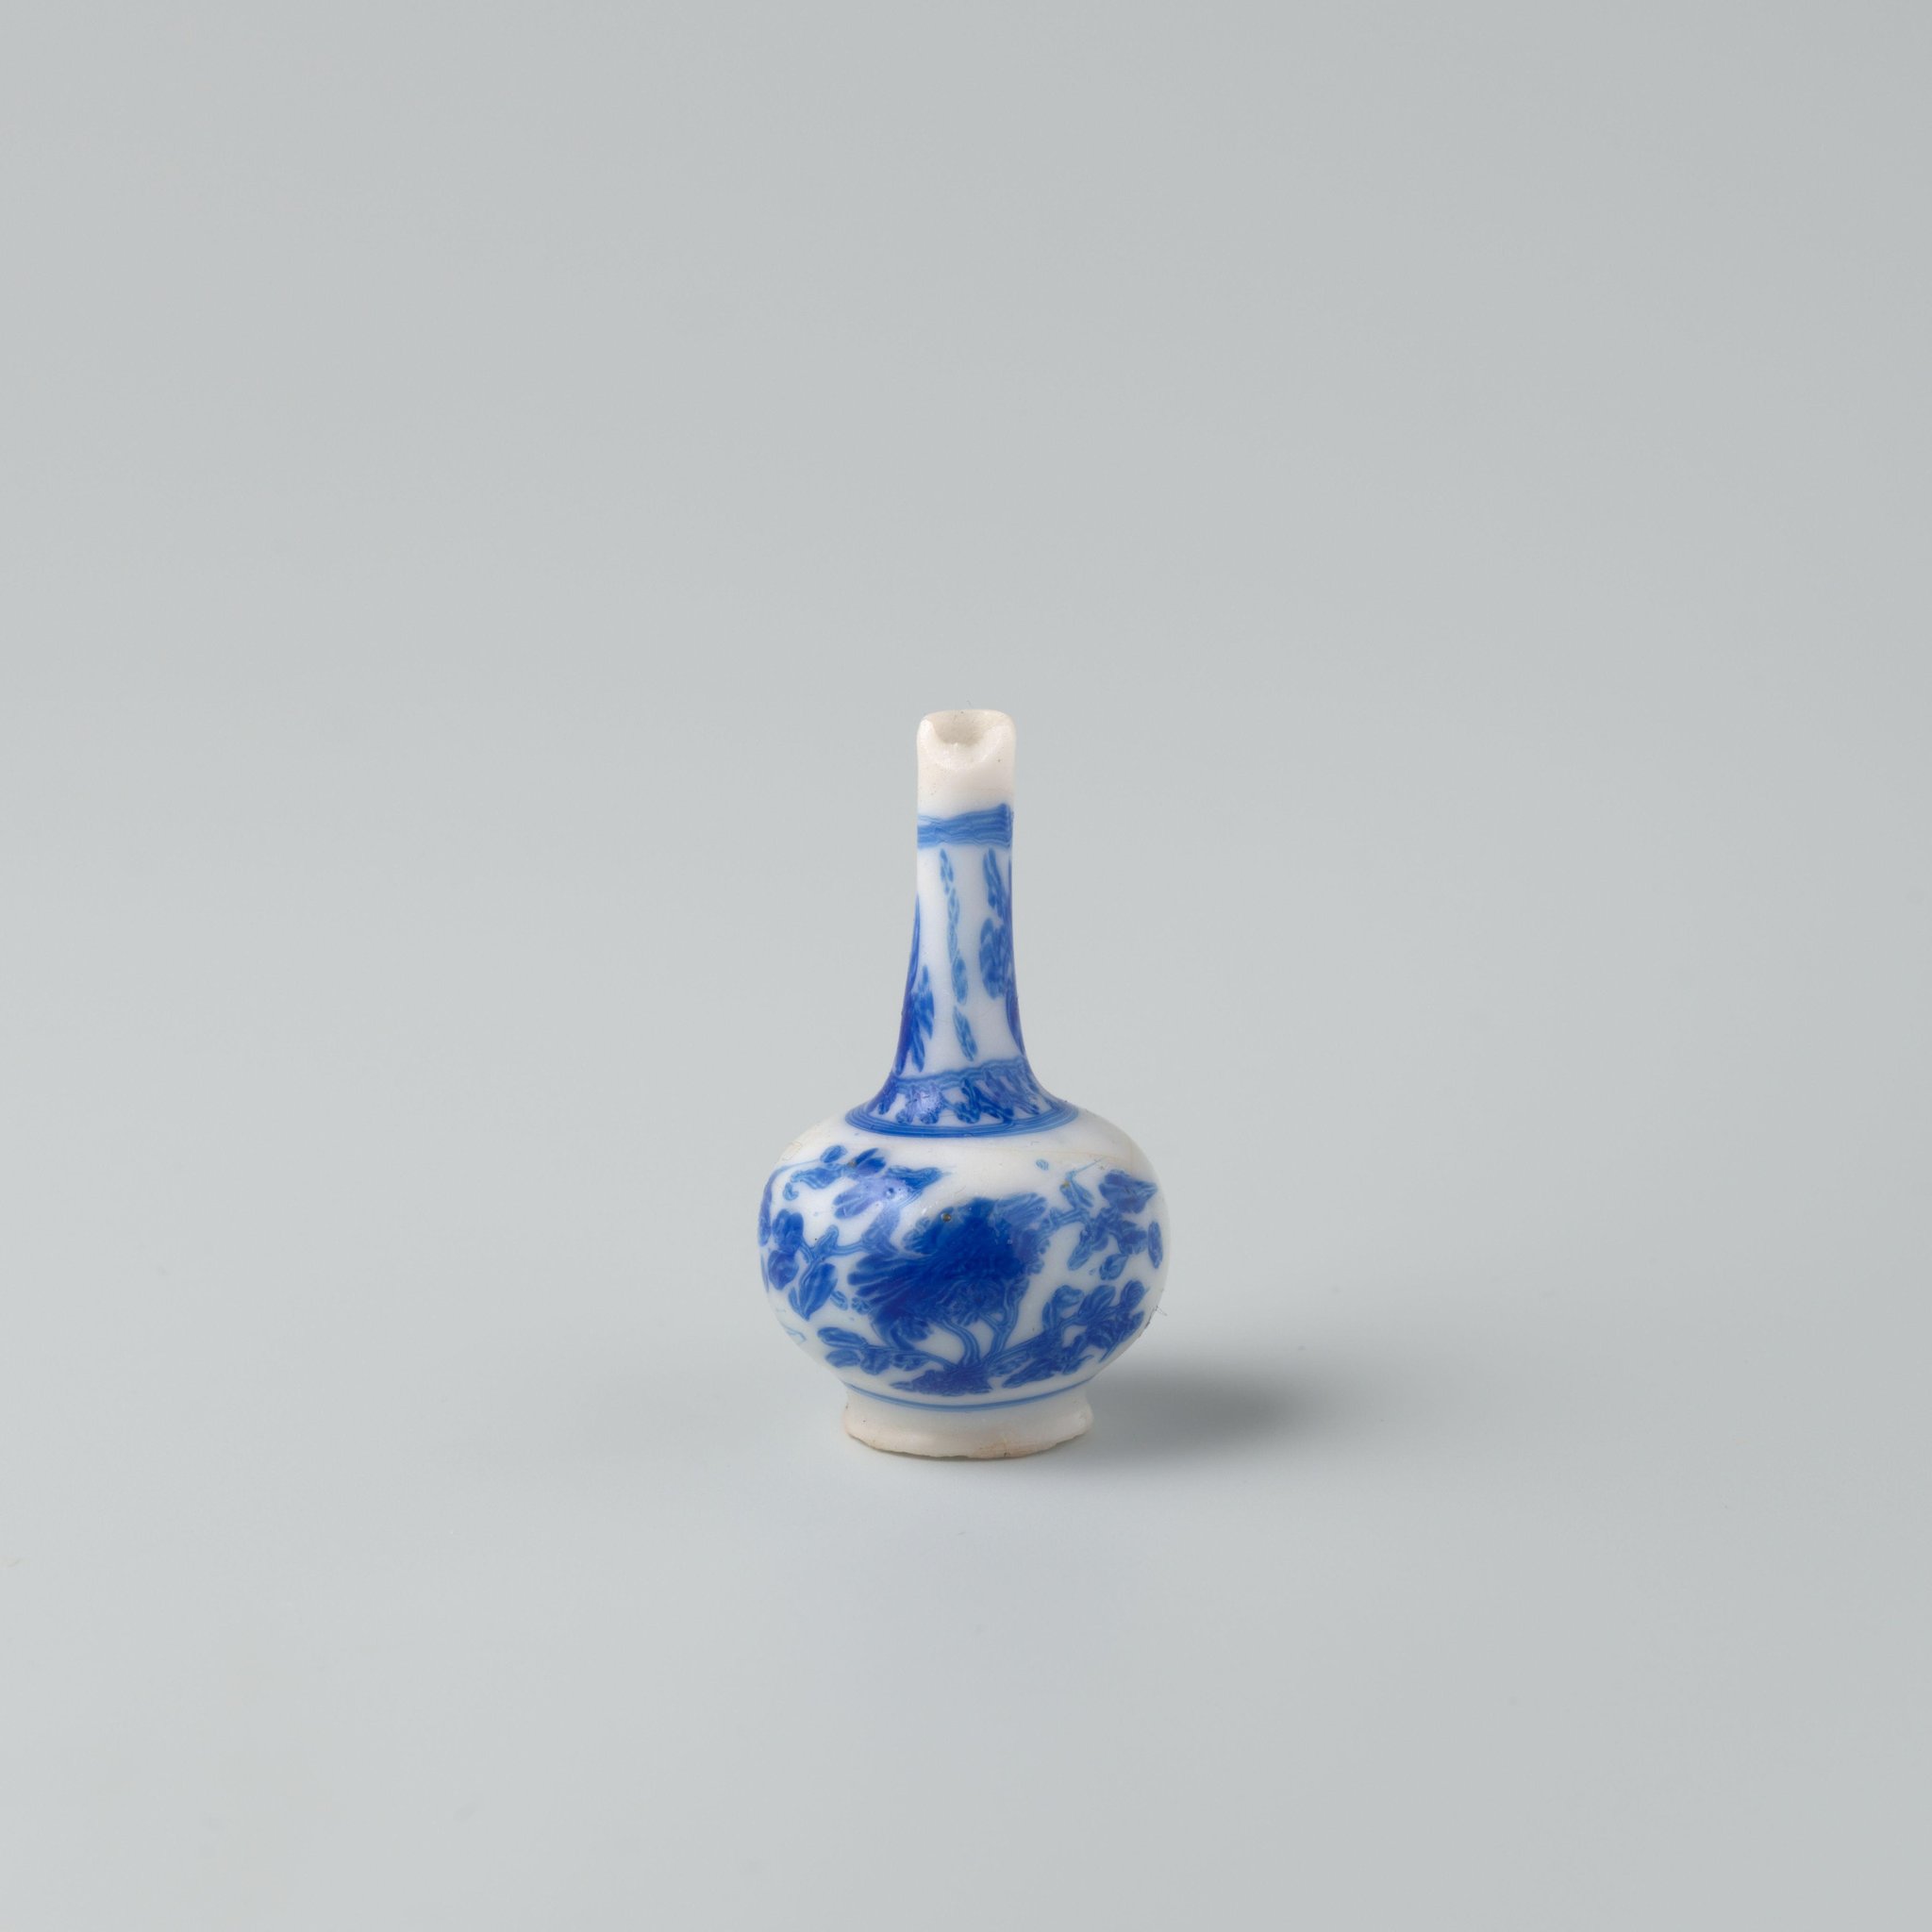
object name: miniature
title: Fles van melkglas met blauwe emailverf beschildering, imitatie Chinees porselein; decoratie van bloesemtakken op bolvormige buik en bloemen in twee vakken op slanke hals.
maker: Anonymous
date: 1675-1710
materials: glass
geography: amsterdam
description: Fles van melkglas met blauw emailverf beschildering, imitatie Chinees blauw porselein; decoratie van bloesemtakken op bolvormige buik en bloemen in twee vakken op slanke hals. Op standring.